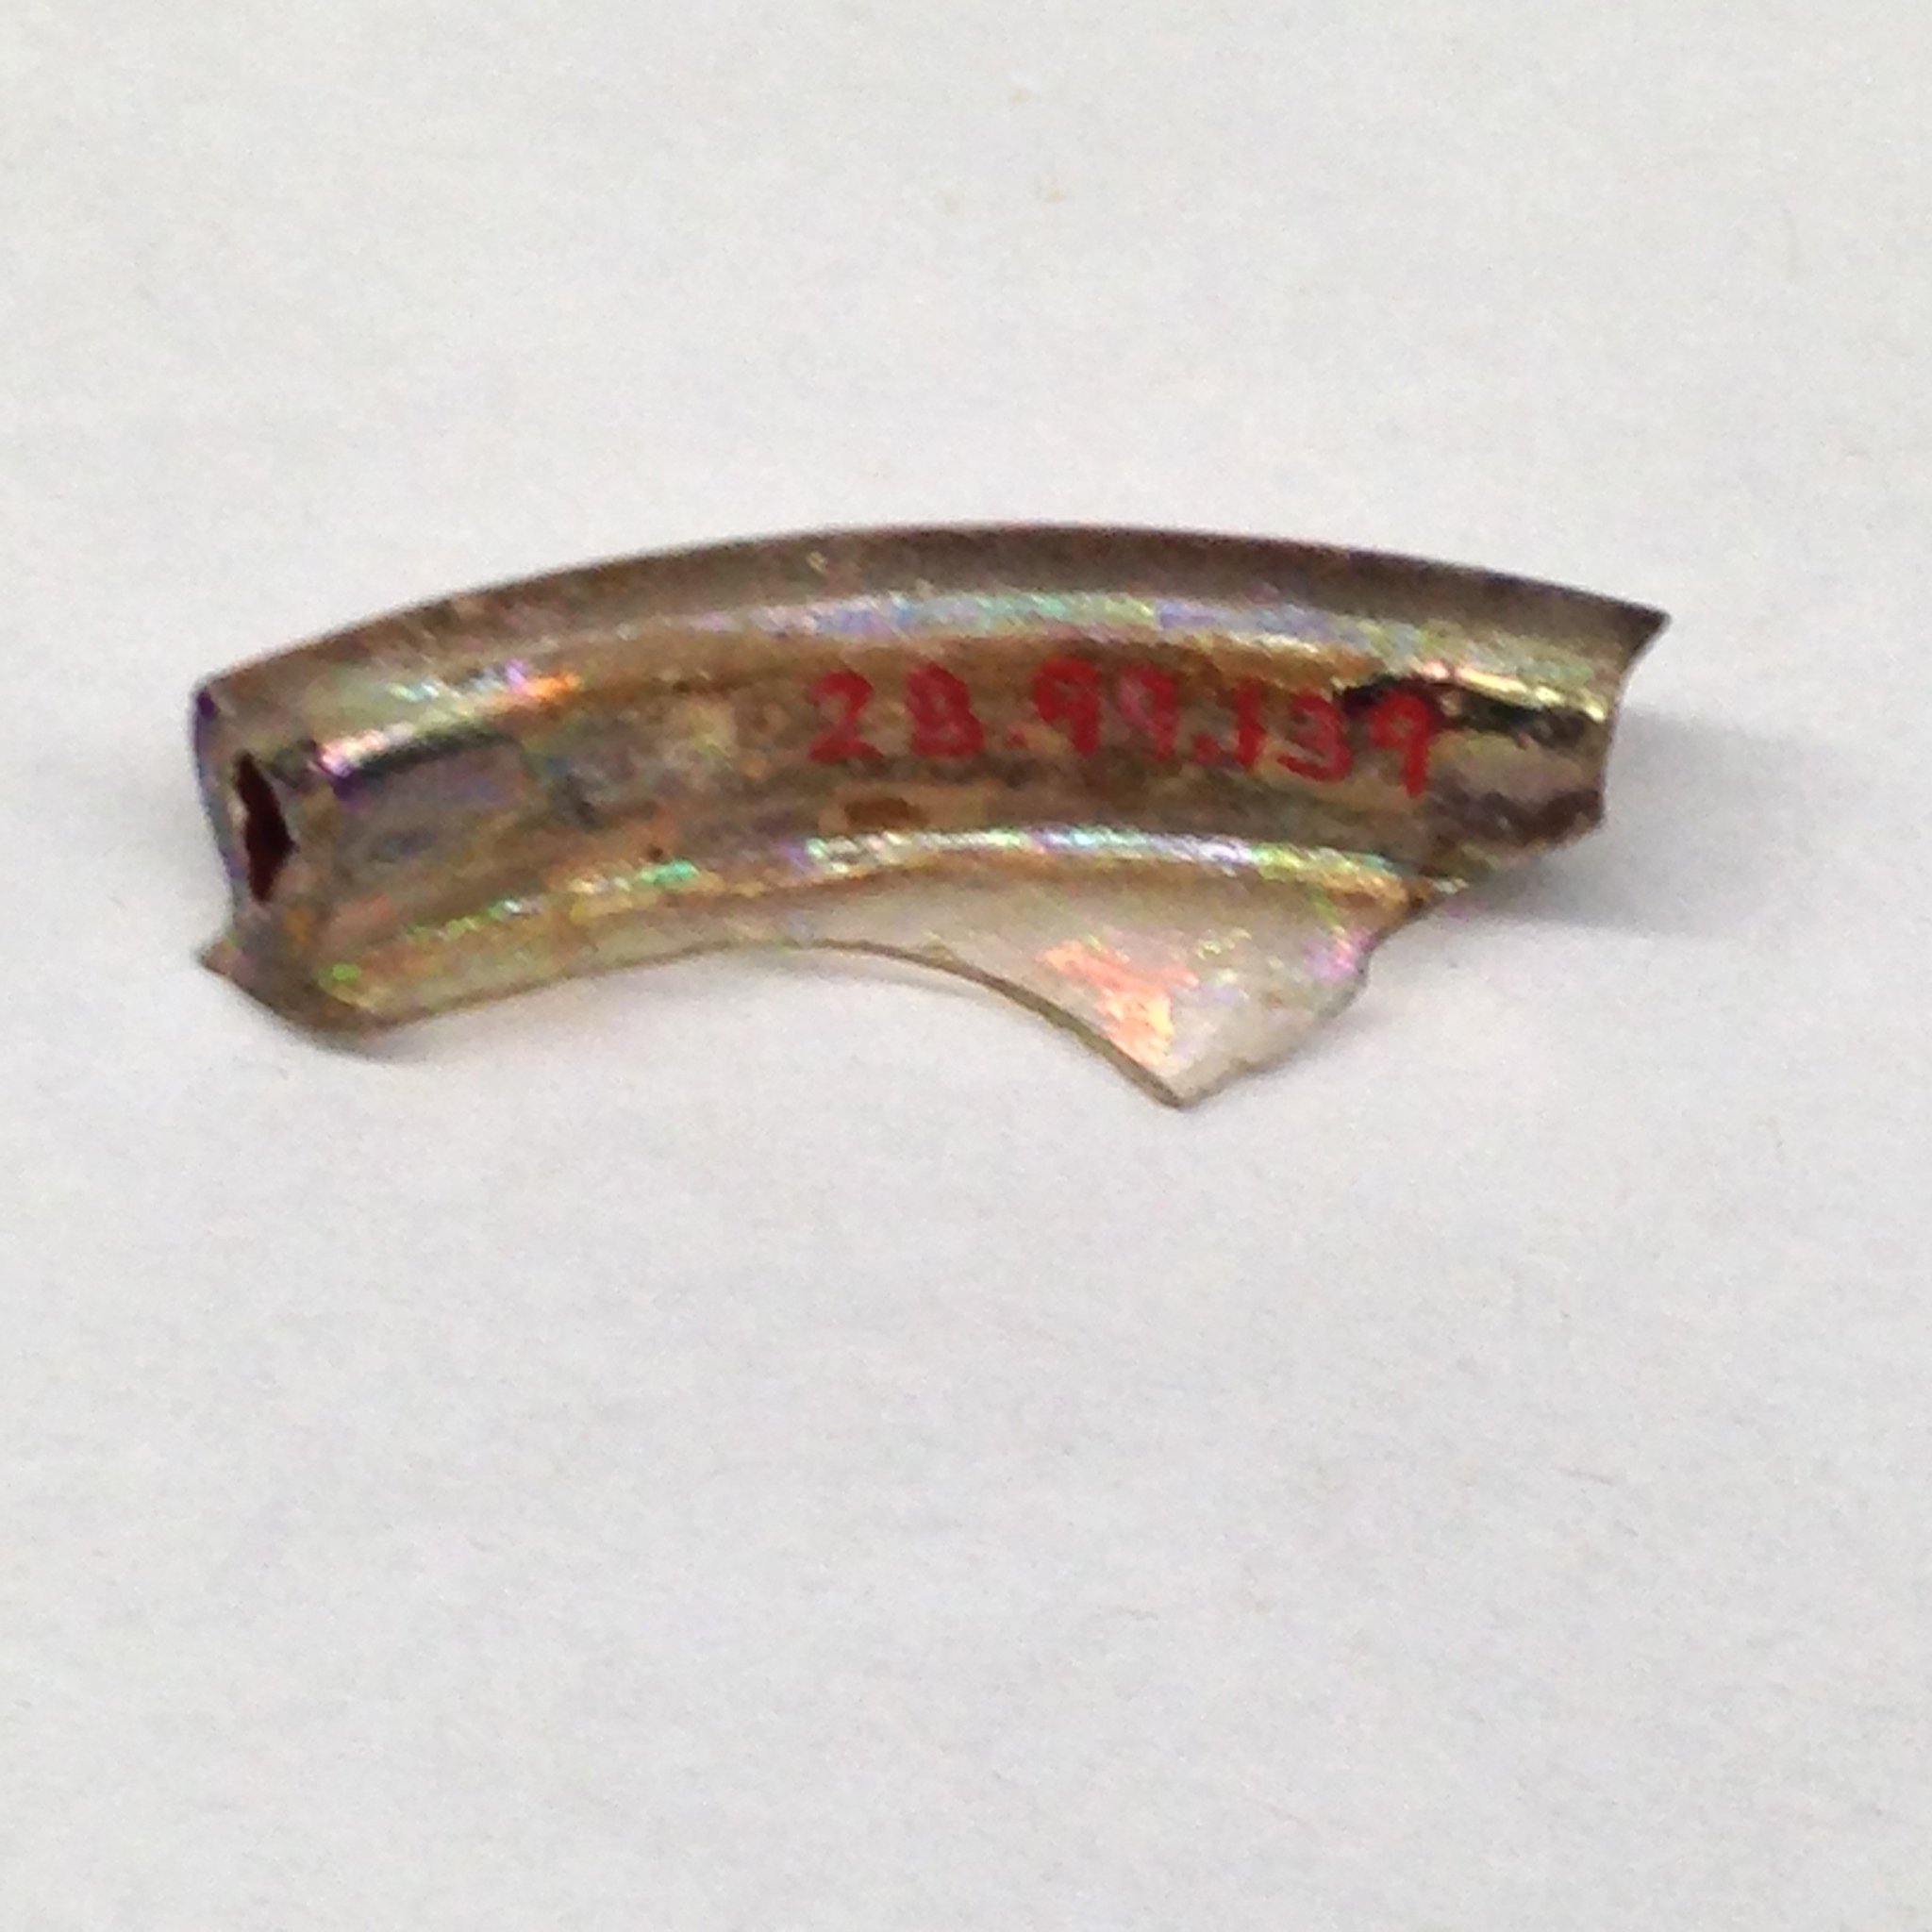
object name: fragment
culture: european or middle eastern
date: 1150-1250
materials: ceramic, glass